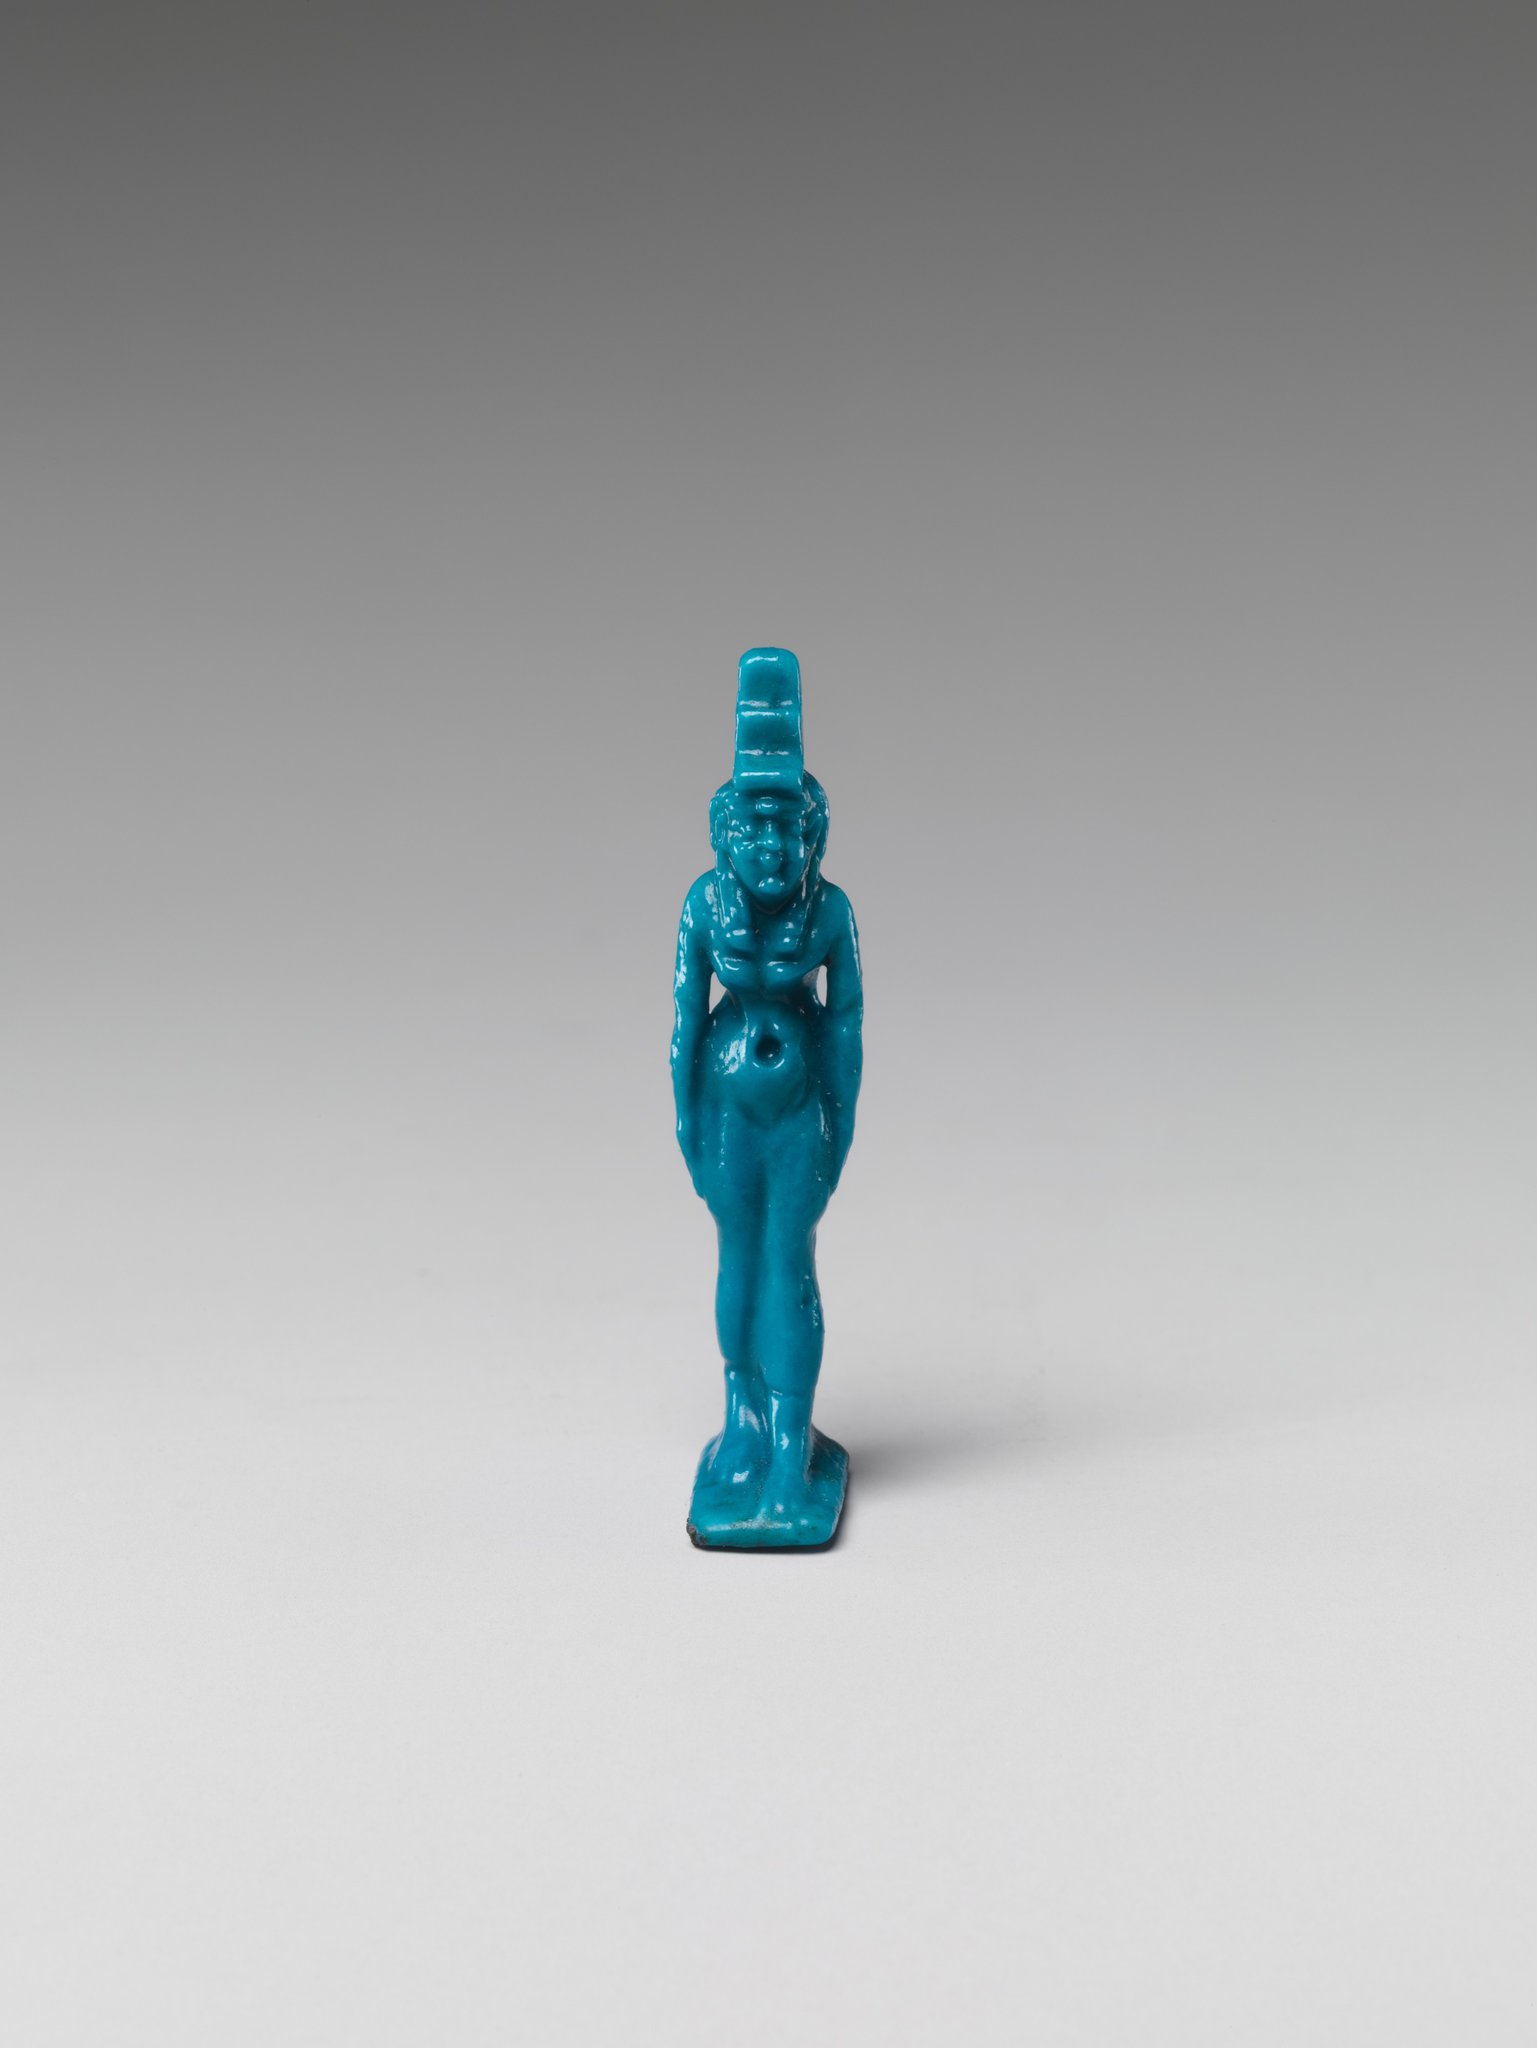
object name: amulet, isi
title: Isis amulet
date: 332-330 BCE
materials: faience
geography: egypt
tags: isis